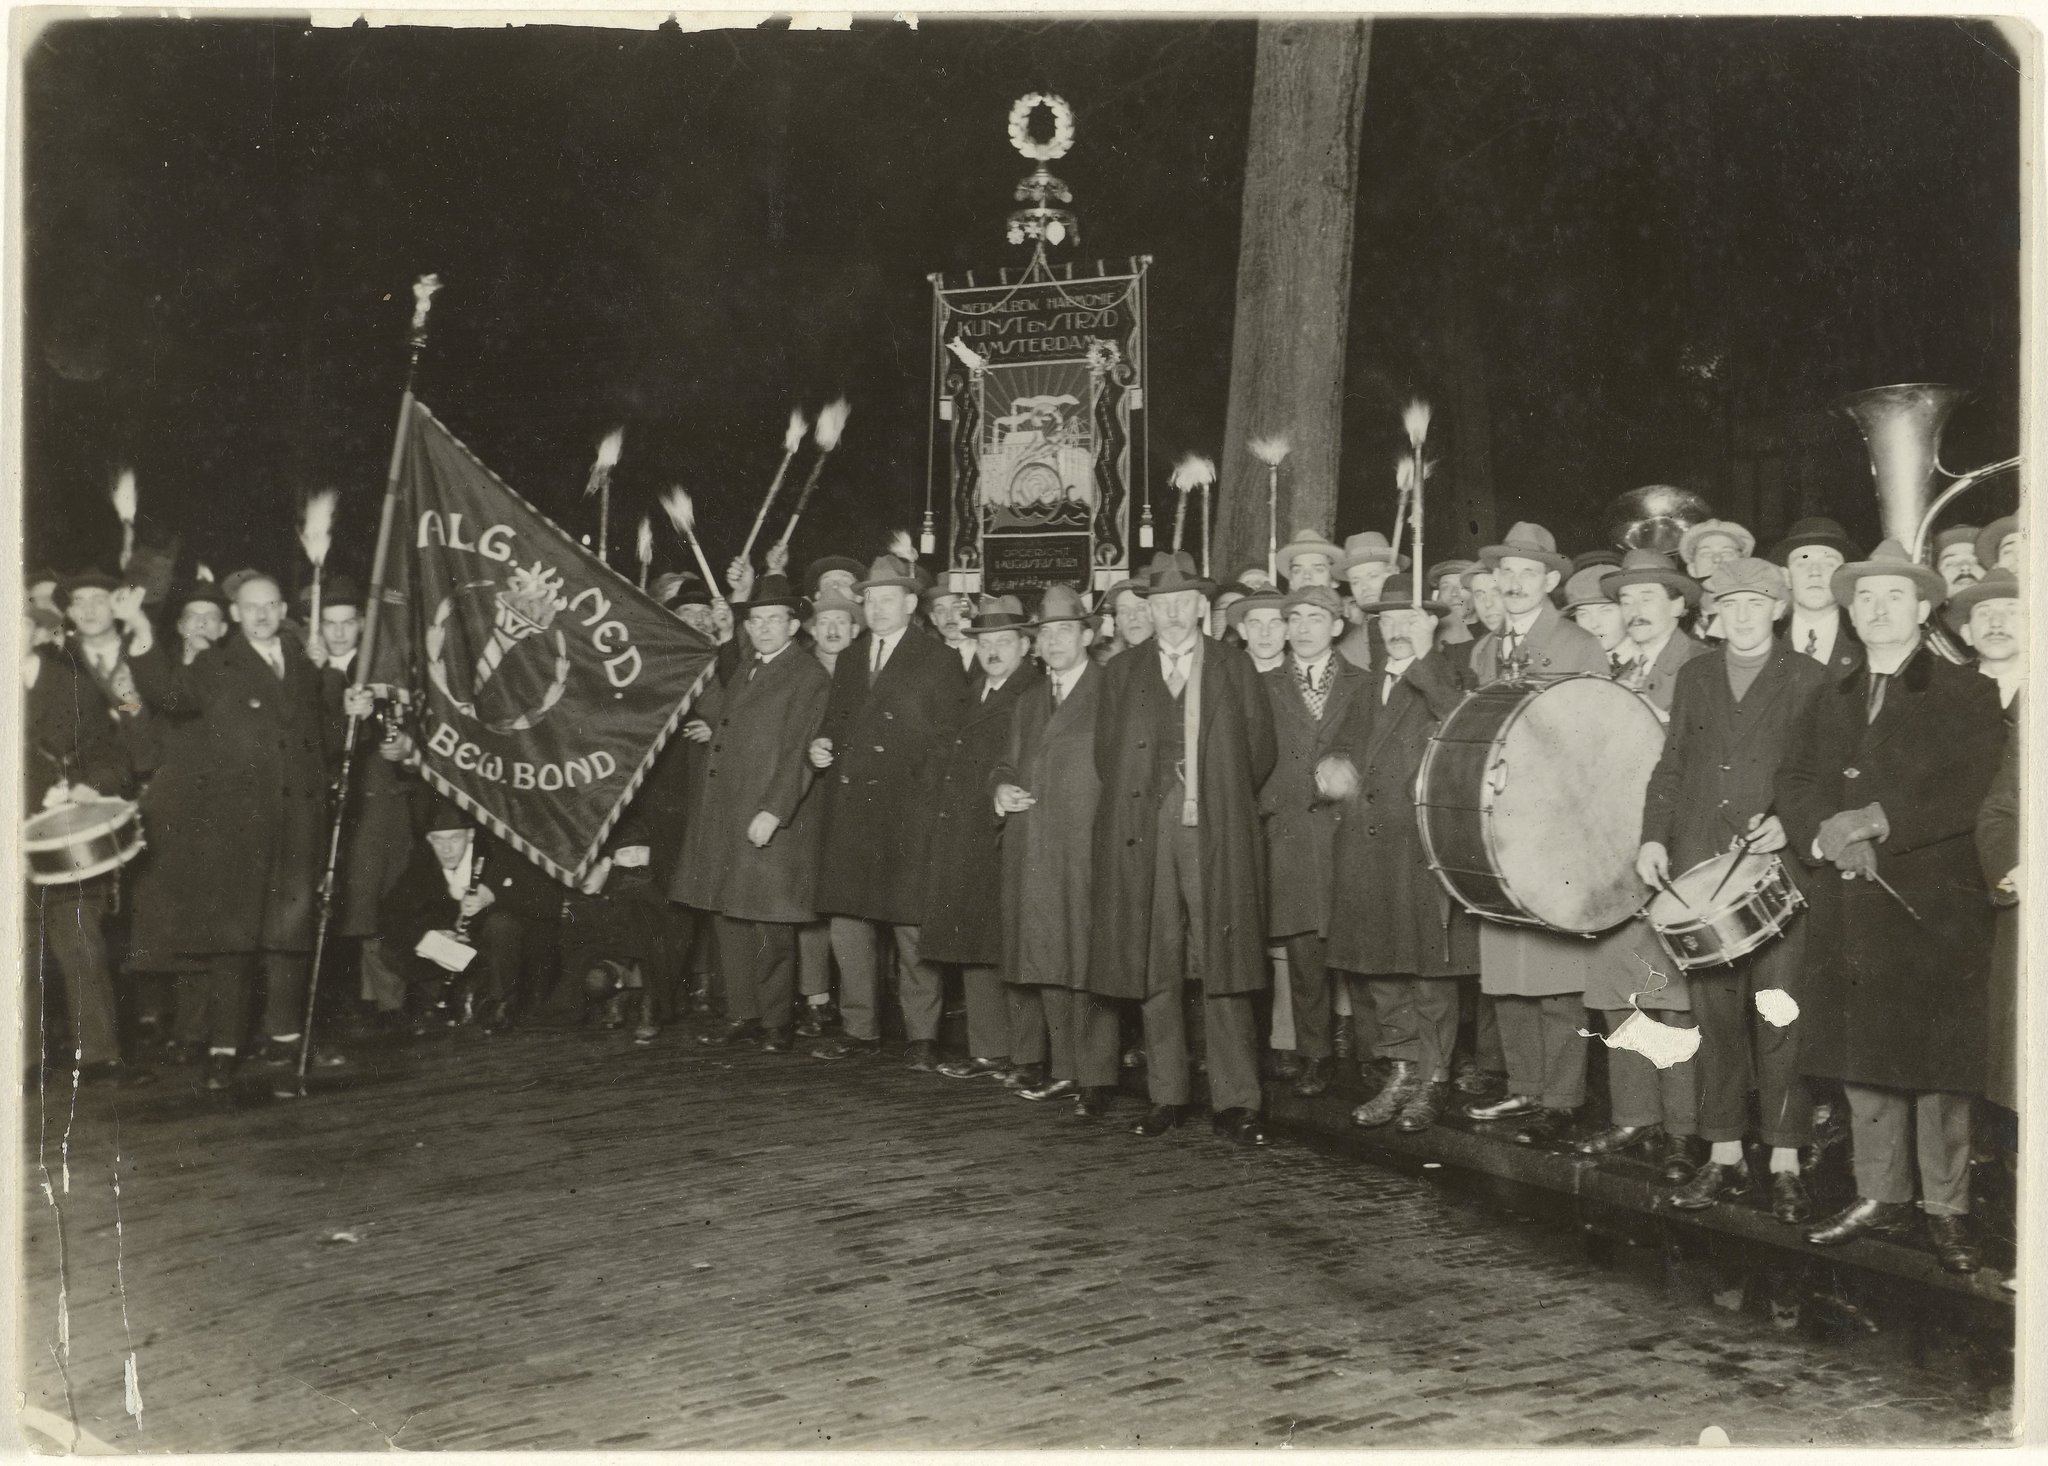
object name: photograph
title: Aubade bij nacht voor 40 jarig bestaan Bond 'Kunst en strijd' in Amsterdam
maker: Anonymous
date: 1926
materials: photographic support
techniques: gelatin silver print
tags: musical instruments; group of musical instruments, making music; musician with instrument, banner, standard (as symbol of the state, etc.), amsterdam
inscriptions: number: ‘5’, stamp: ‘copyright int. persfoto bureau Amsterdam’